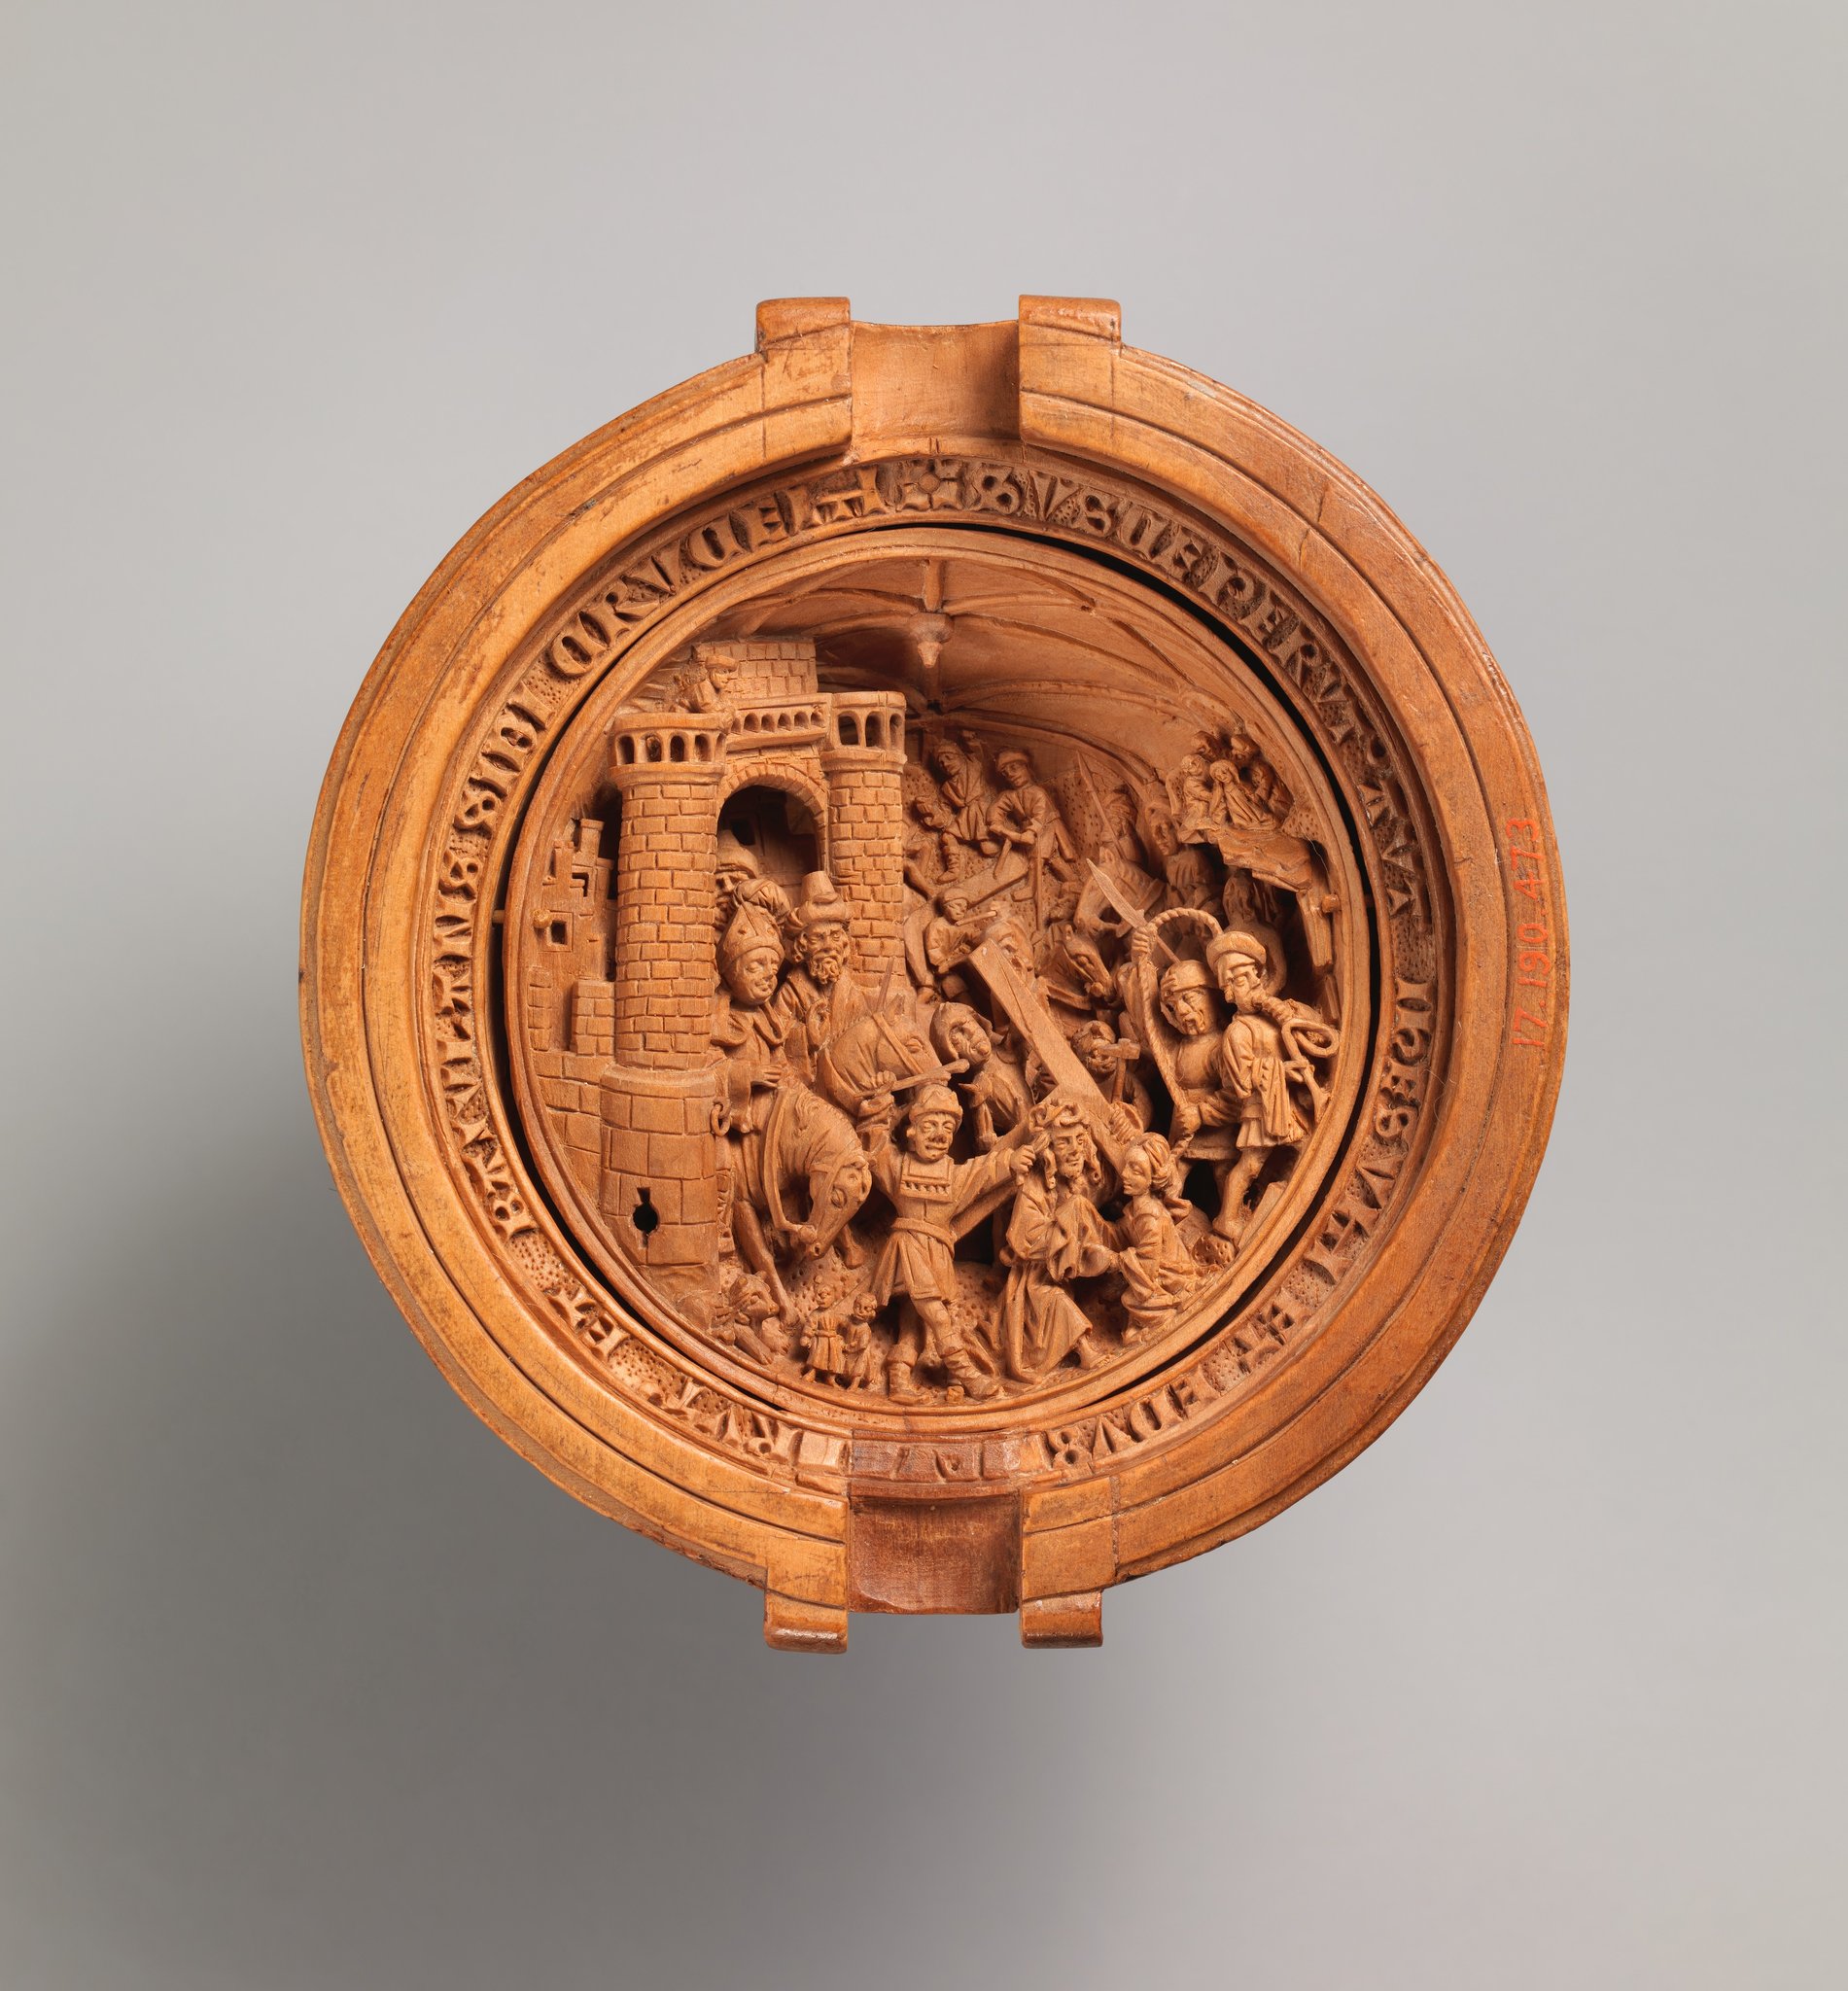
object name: prayer bead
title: Half of a Prayer Bead with Jesus Carrying the Cross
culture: dutch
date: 1501-1533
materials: wood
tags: men,christ,bearing the cross